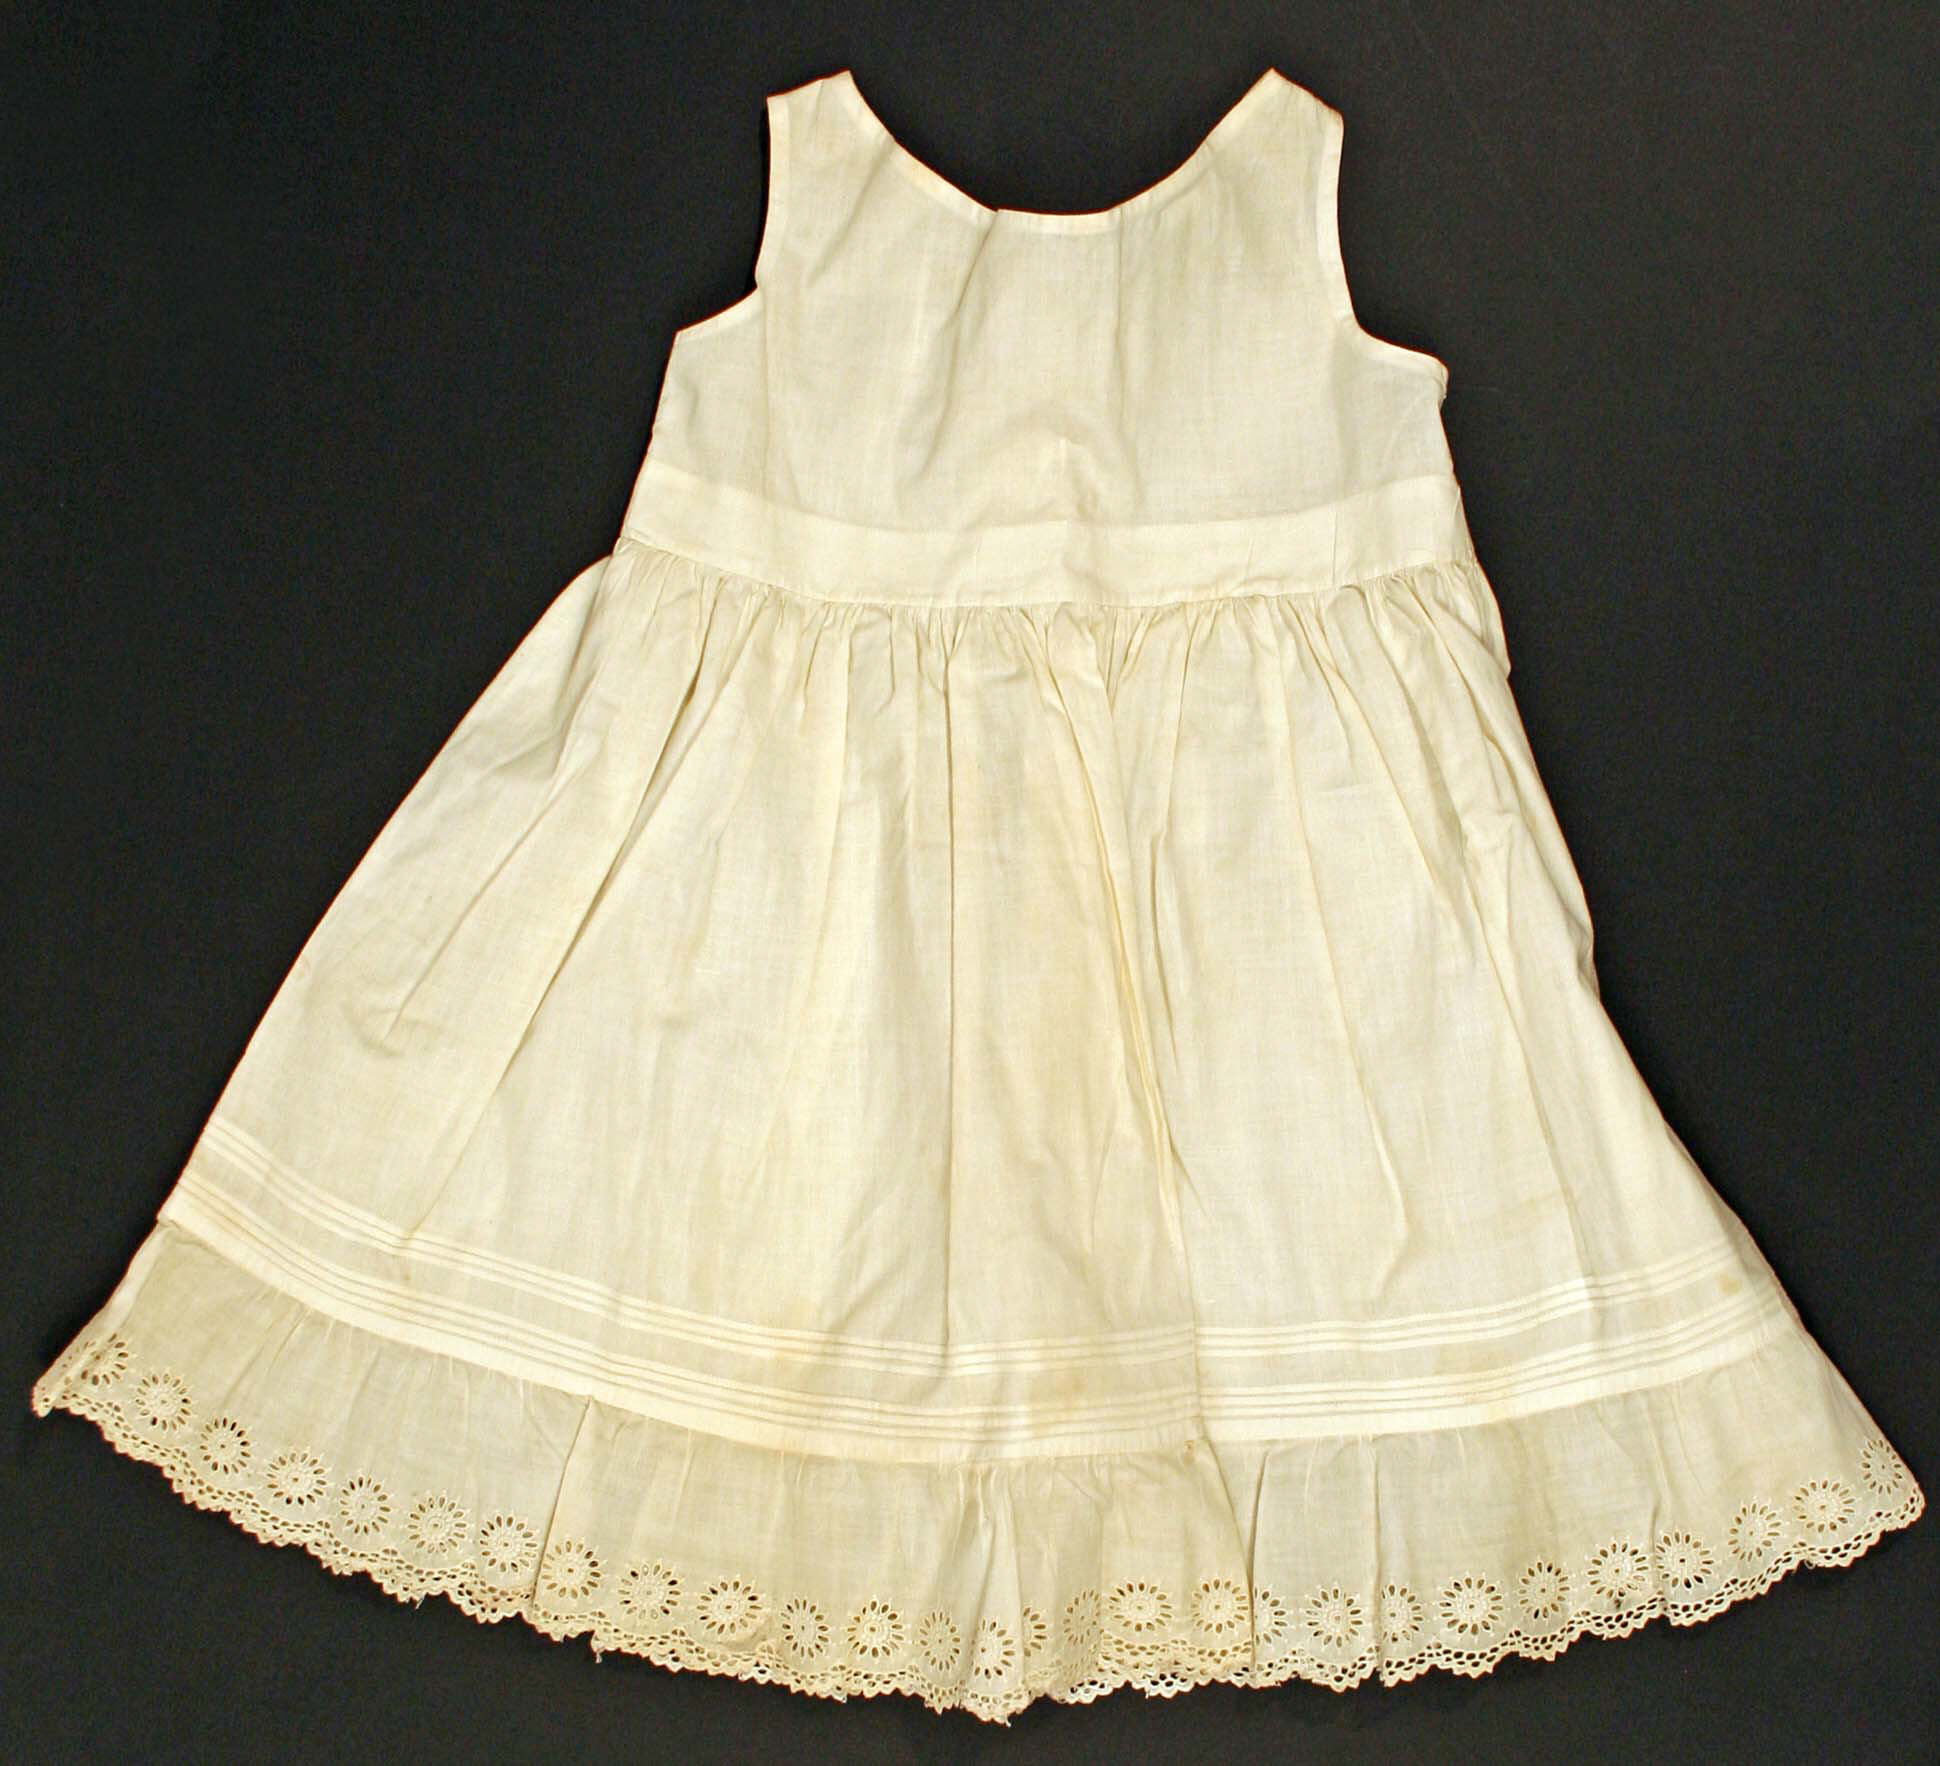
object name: petticoat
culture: american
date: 1890-1899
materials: cotton